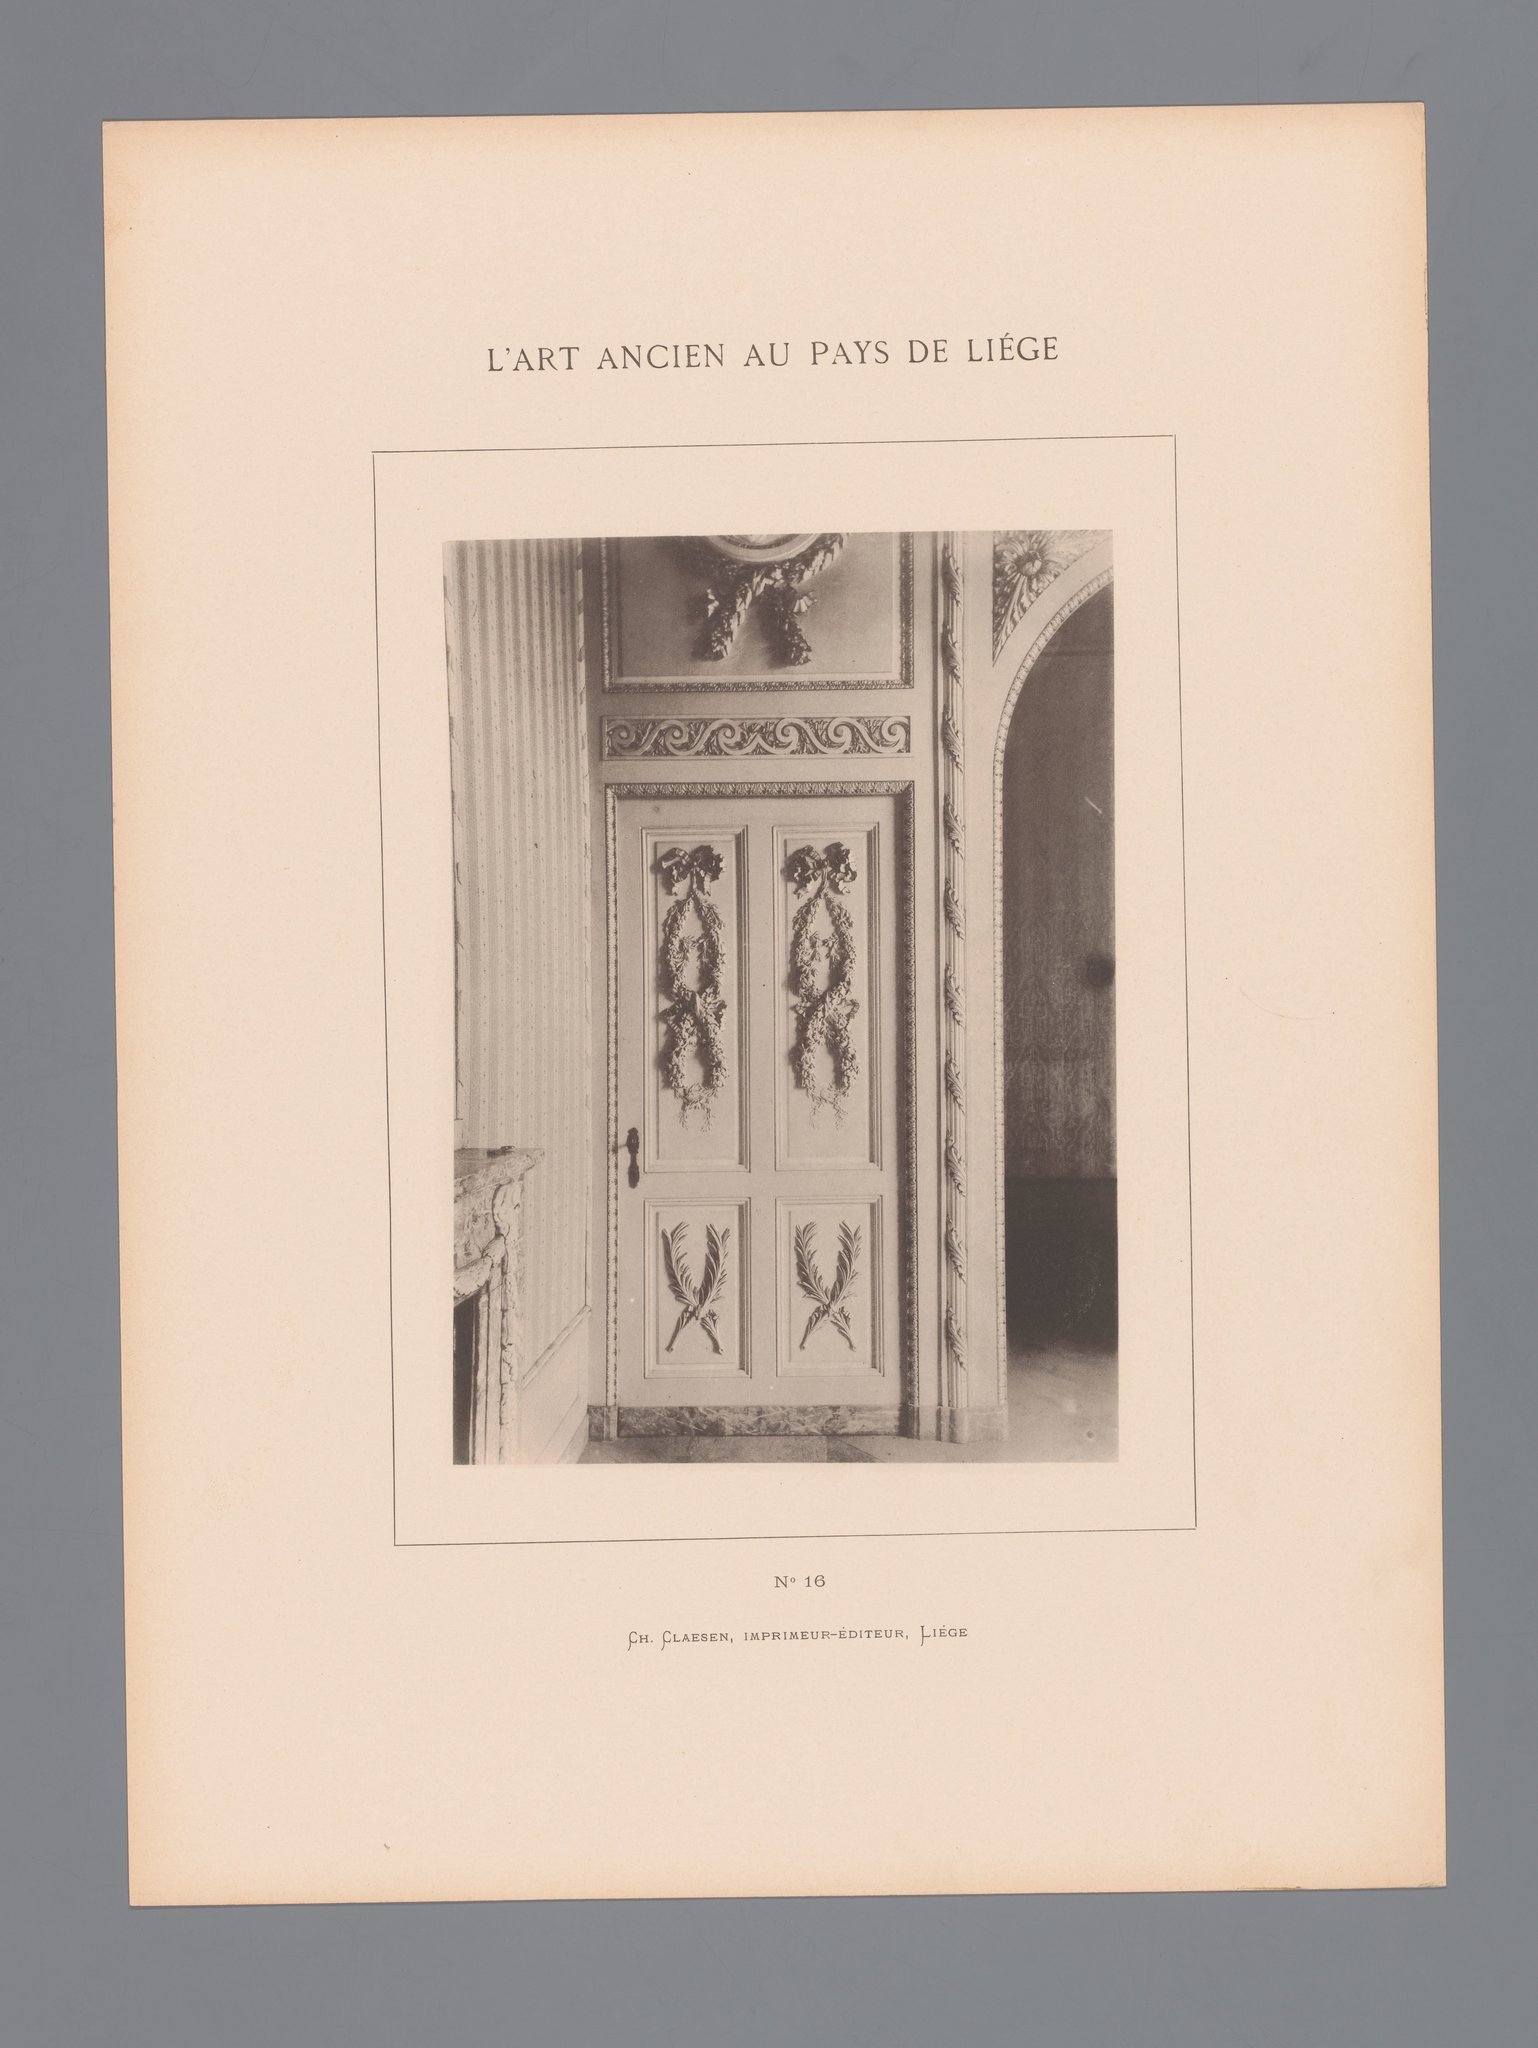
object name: photomechanical print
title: Gedecoreerde deur in de oude prefectuur in Luik, België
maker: Anonymous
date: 1879-1884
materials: paper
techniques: photograph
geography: liège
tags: interior of the house, closed door, liège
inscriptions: number: ‘No 16’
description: Deze prent maakt deel uit van een omslag met twintig prenten, een titelblad en een lijst van afbeeldingen.